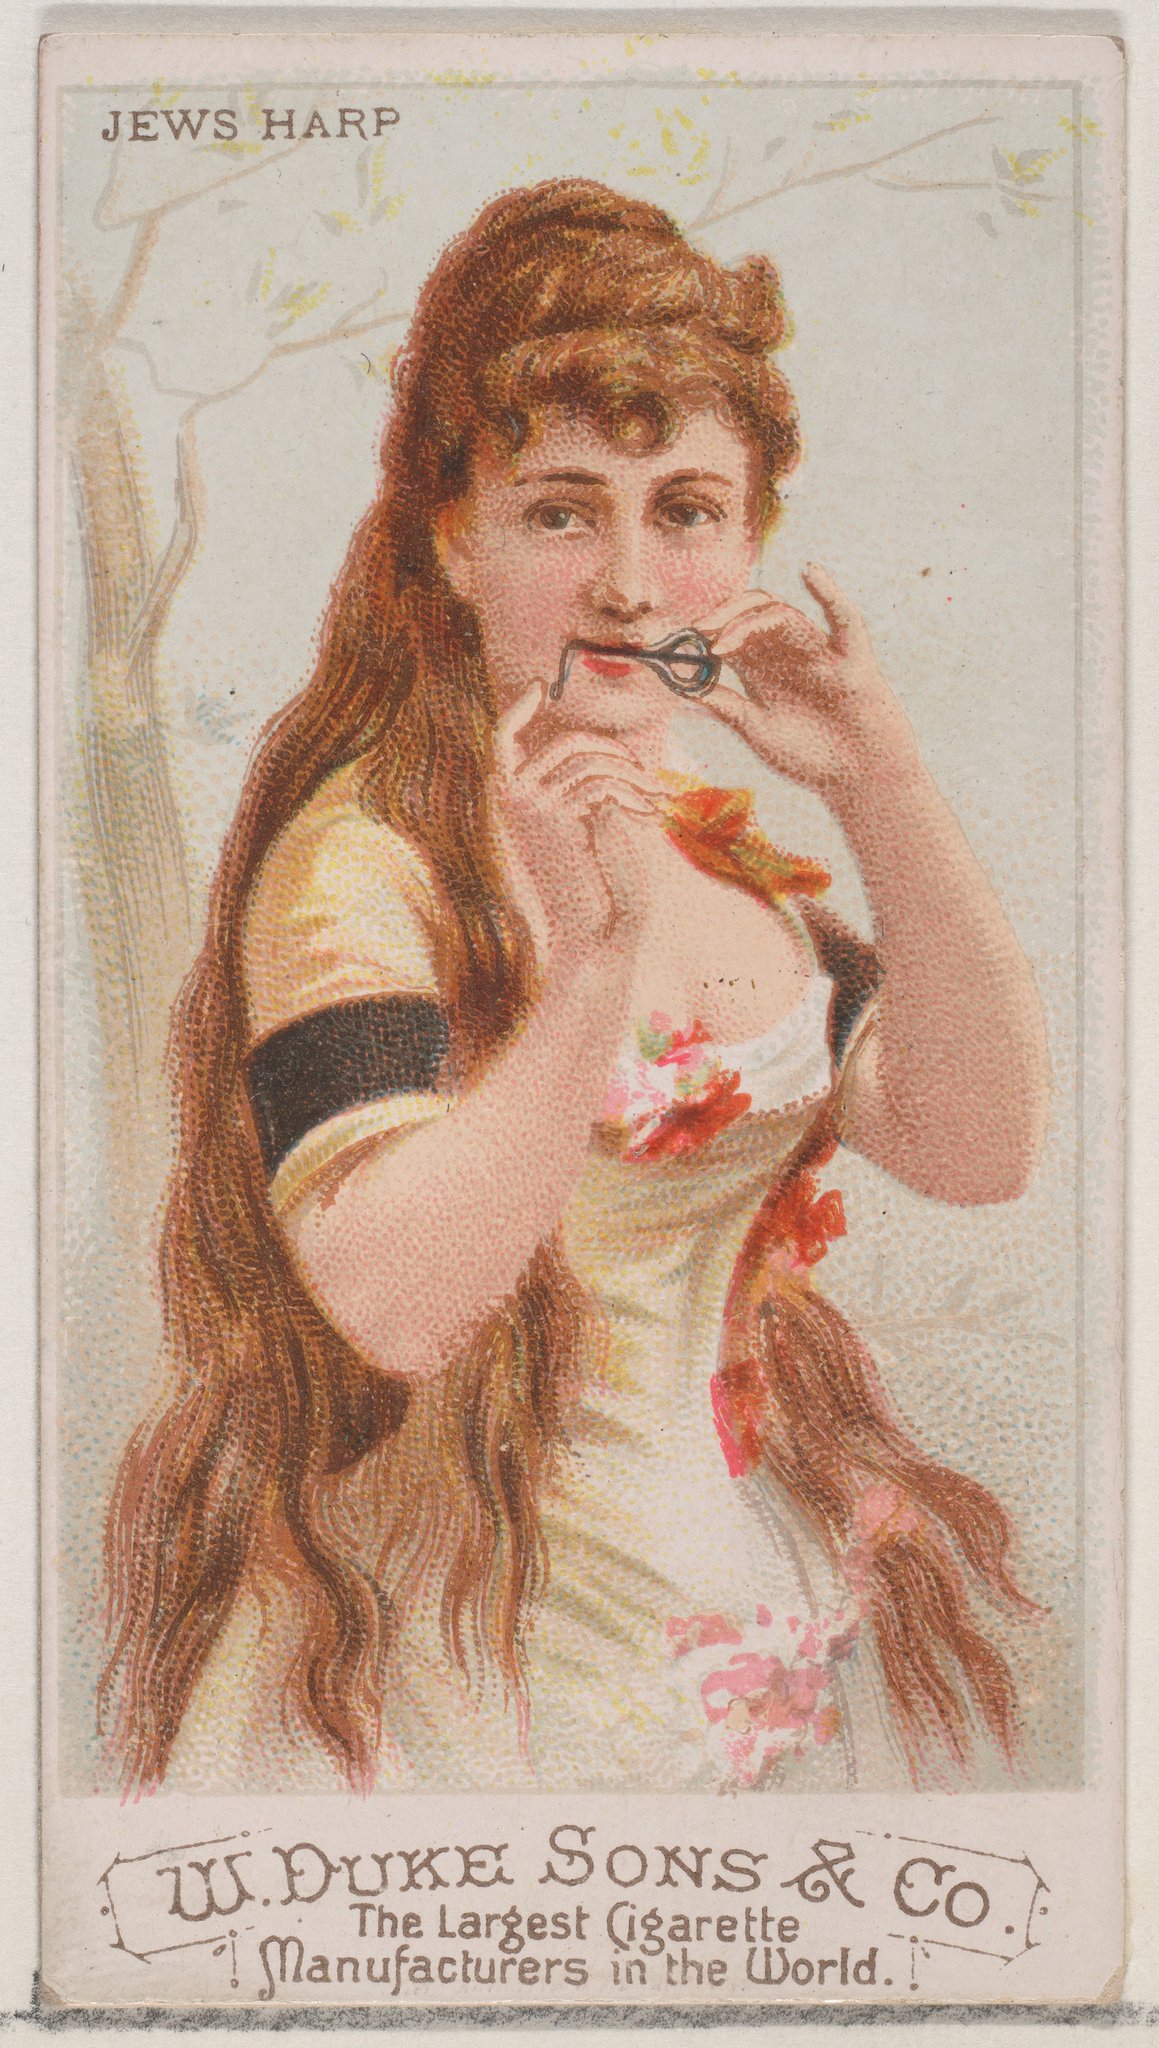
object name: print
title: Jews Harp, from the Musical Instruments series (N82) for Duke brand cigarettes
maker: w. duke, sons & co.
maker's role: publisher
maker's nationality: american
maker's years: 1870-1920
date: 1888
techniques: color lithograph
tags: musical instruments,women,musicians